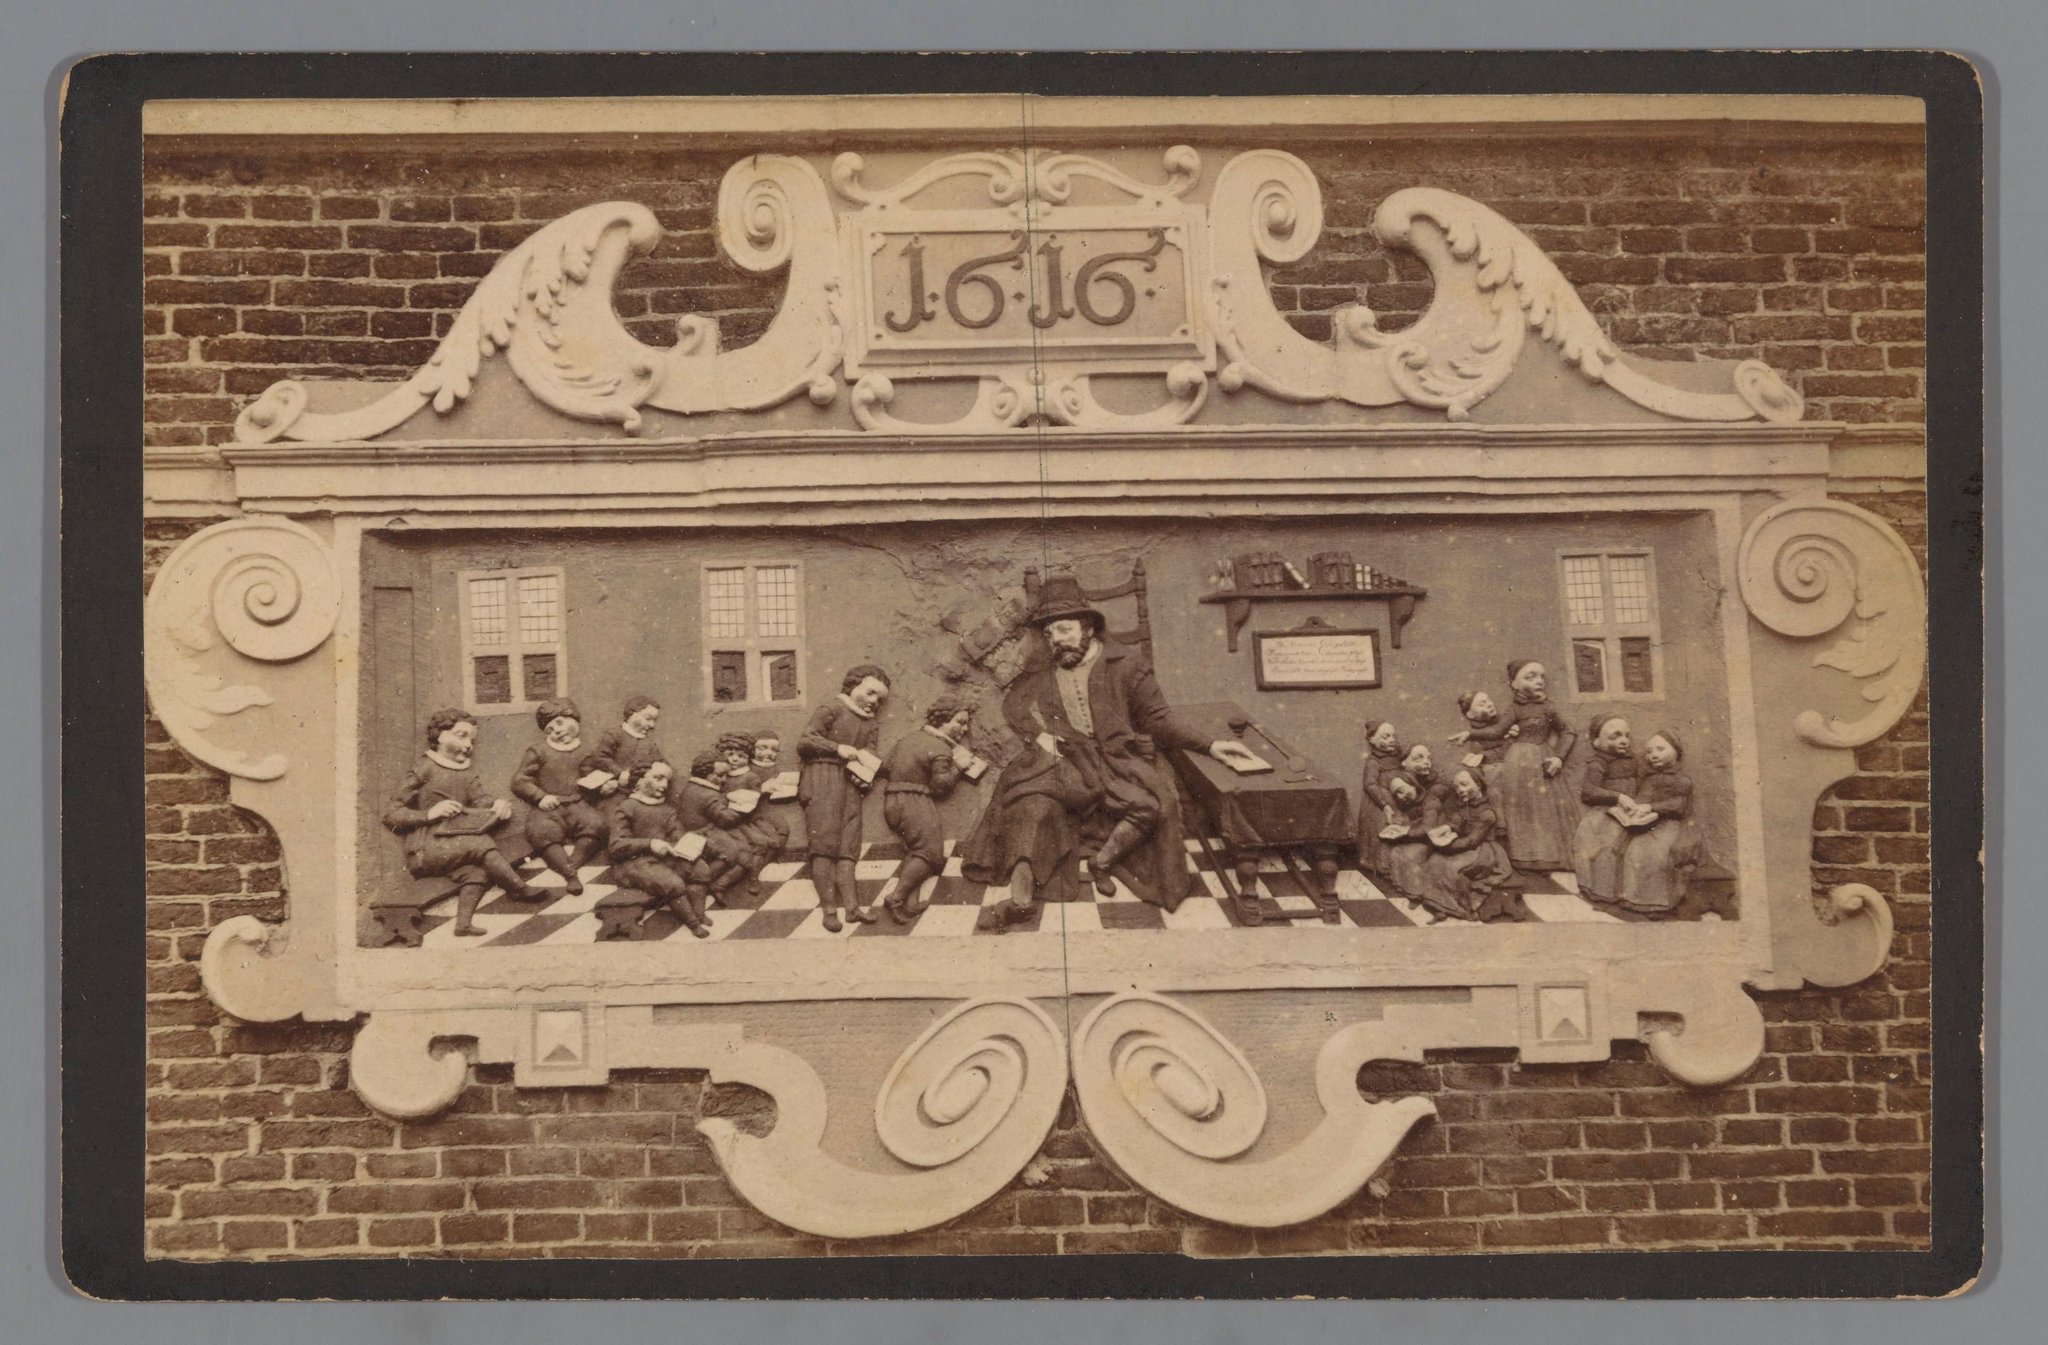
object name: photograph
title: Reliëf met een afbeelding van een schoolklas op de muur boven de poort van het weeshuis aan de Westerstraat in Enkhuizen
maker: albert dekema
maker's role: publisher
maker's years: 1824-1909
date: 1865-1896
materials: cardboard, photographic support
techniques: albumen print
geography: enkhuizen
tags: orphanage, sculpture (+ relief ~ sculpture), enkhuizen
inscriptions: annotation: ‘Weeshuis Enkhuizen’